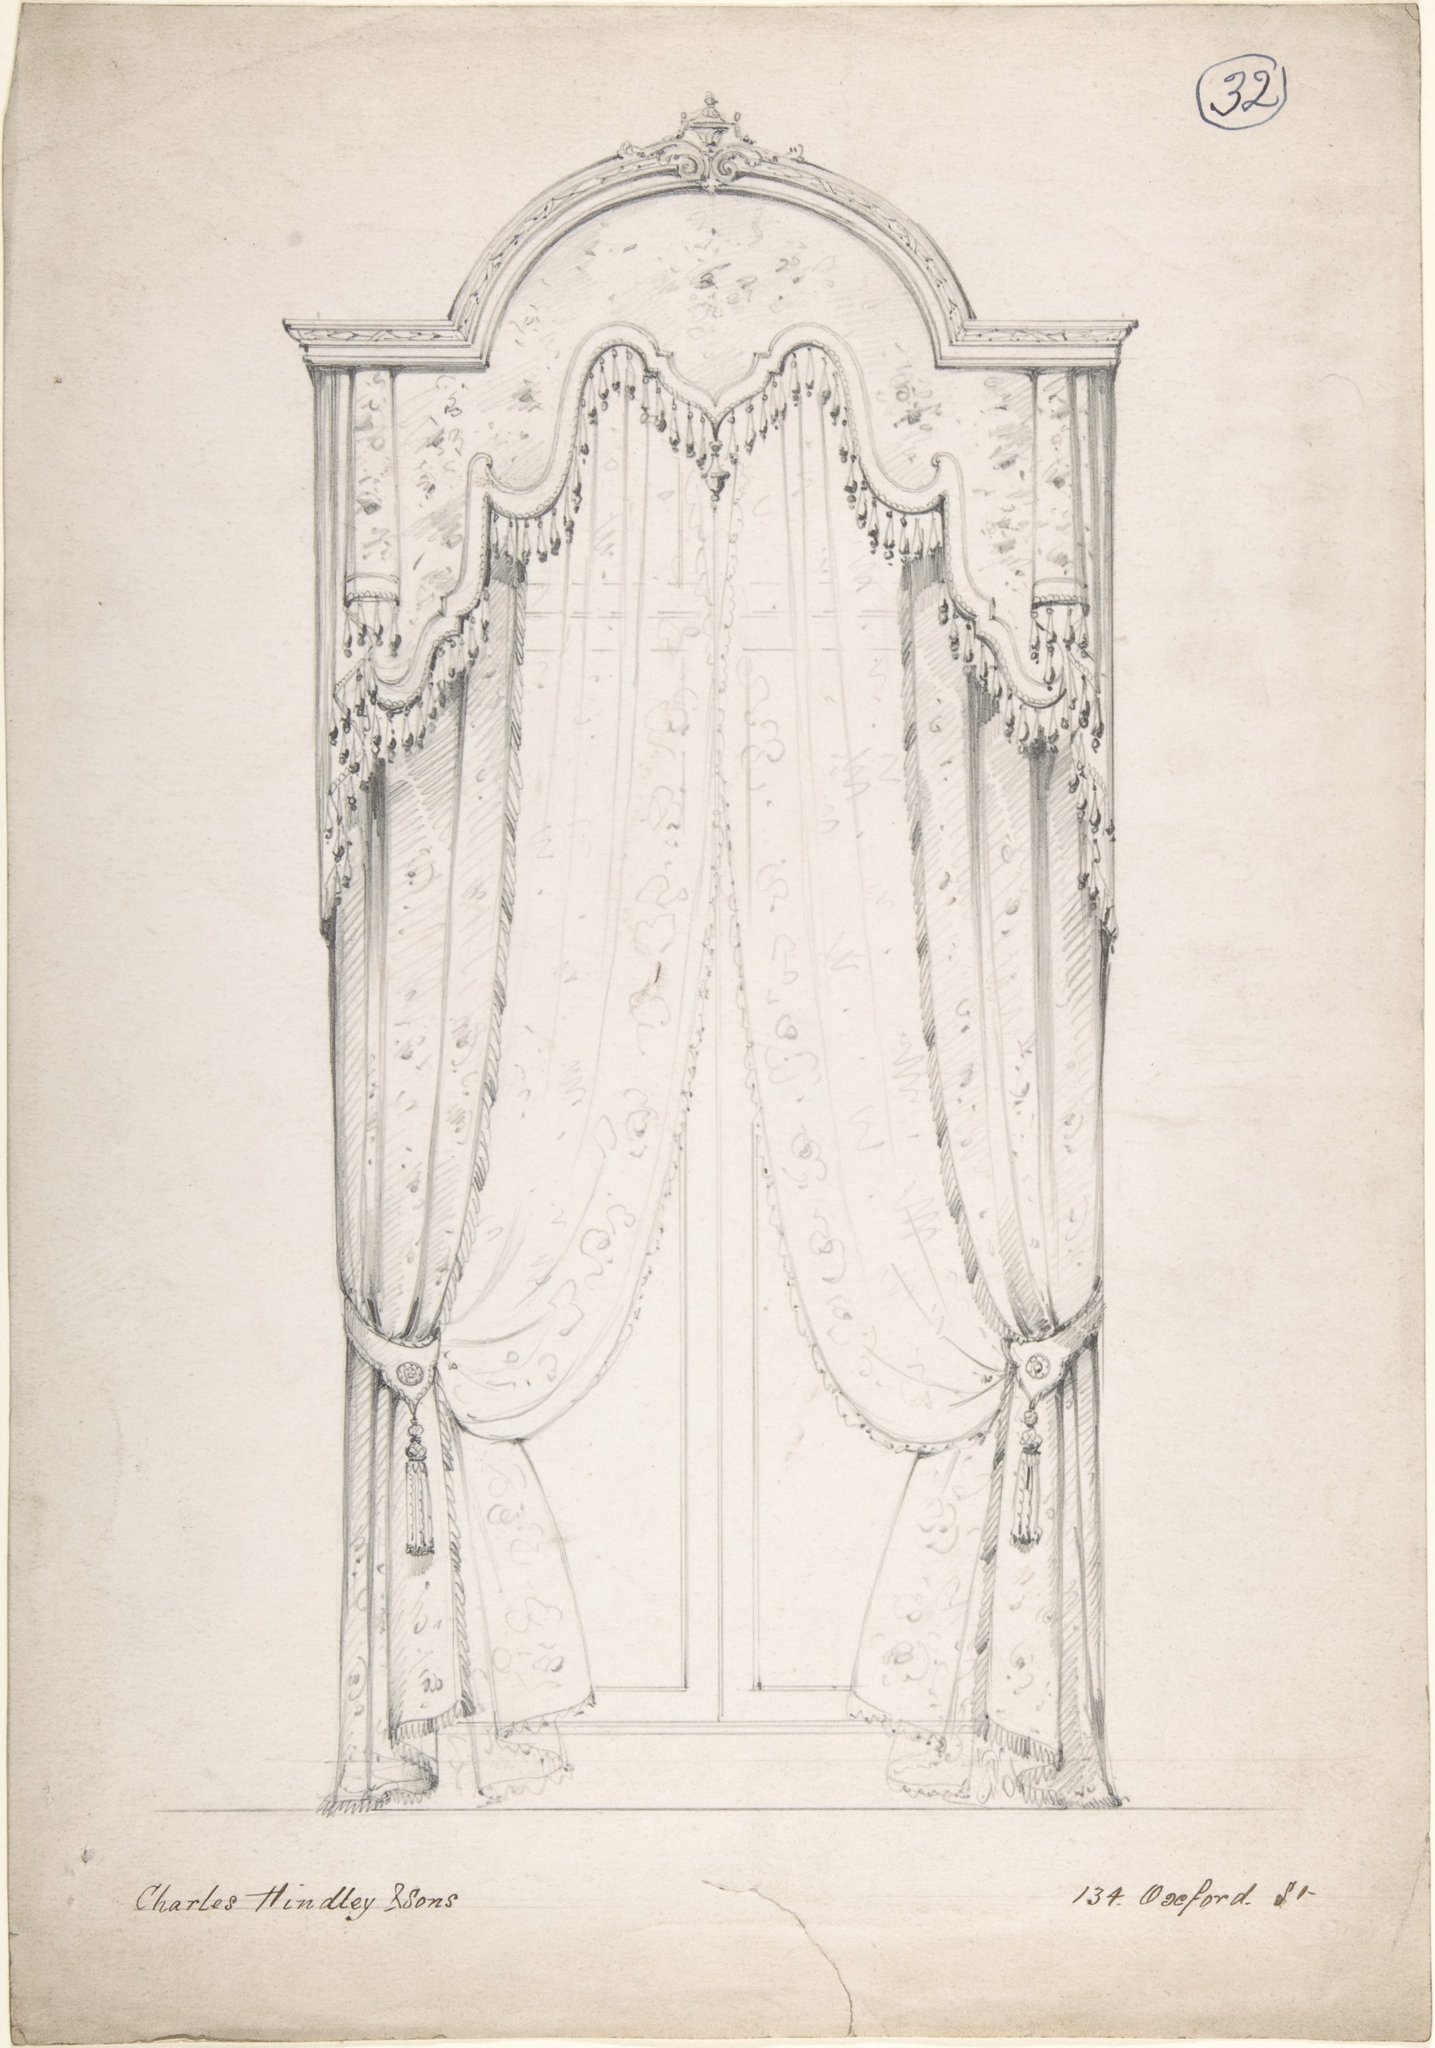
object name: drawing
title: Design for Curtains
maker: charles hindley and sons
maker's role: artist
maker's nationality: british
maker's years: 1841-1917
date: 1841-1884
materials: graphite, watercolor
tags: curtains